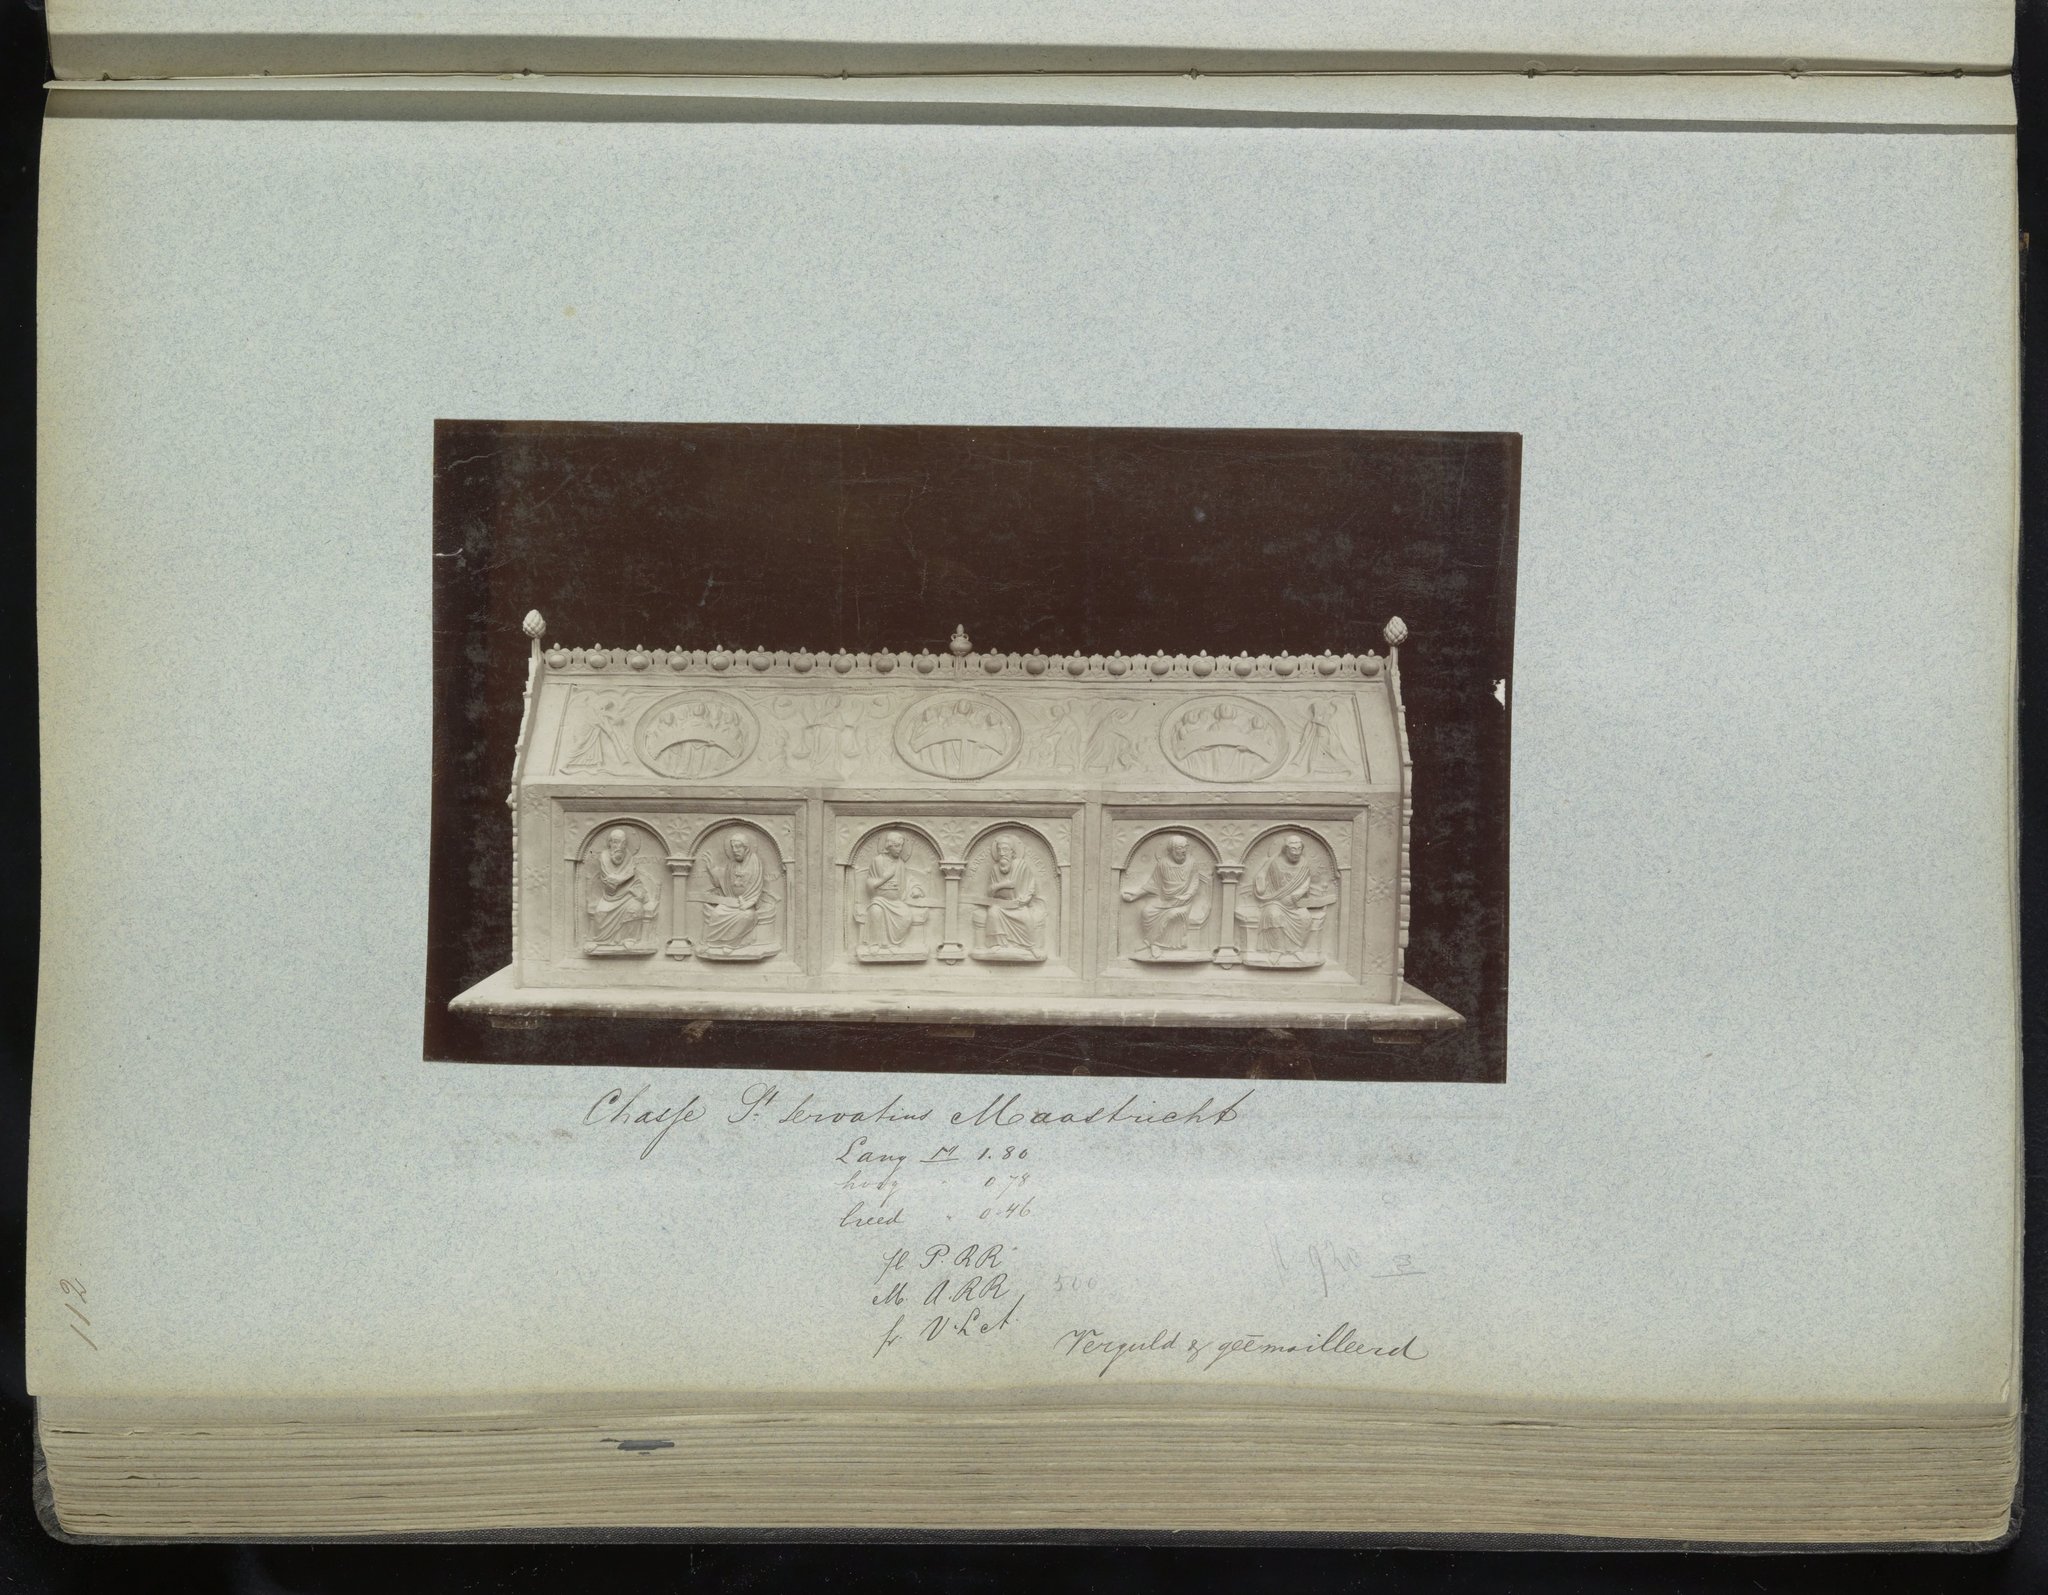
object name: photograph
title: Gipsen afgietsel van een reliekschrijn van de Sint-Servaasbasiliek te Maastricht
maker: Anonymous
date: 1875-1900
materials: paper, photographic support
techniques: albumen print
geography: maastricht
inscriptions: annotation, annotation: ‘[...] St. Servatius Maastricht’, annotation: ‘Lang M 1.80 / hoog 0.78 / breed 0.46’, annotation: ‘Verguld en geëmailleerd’